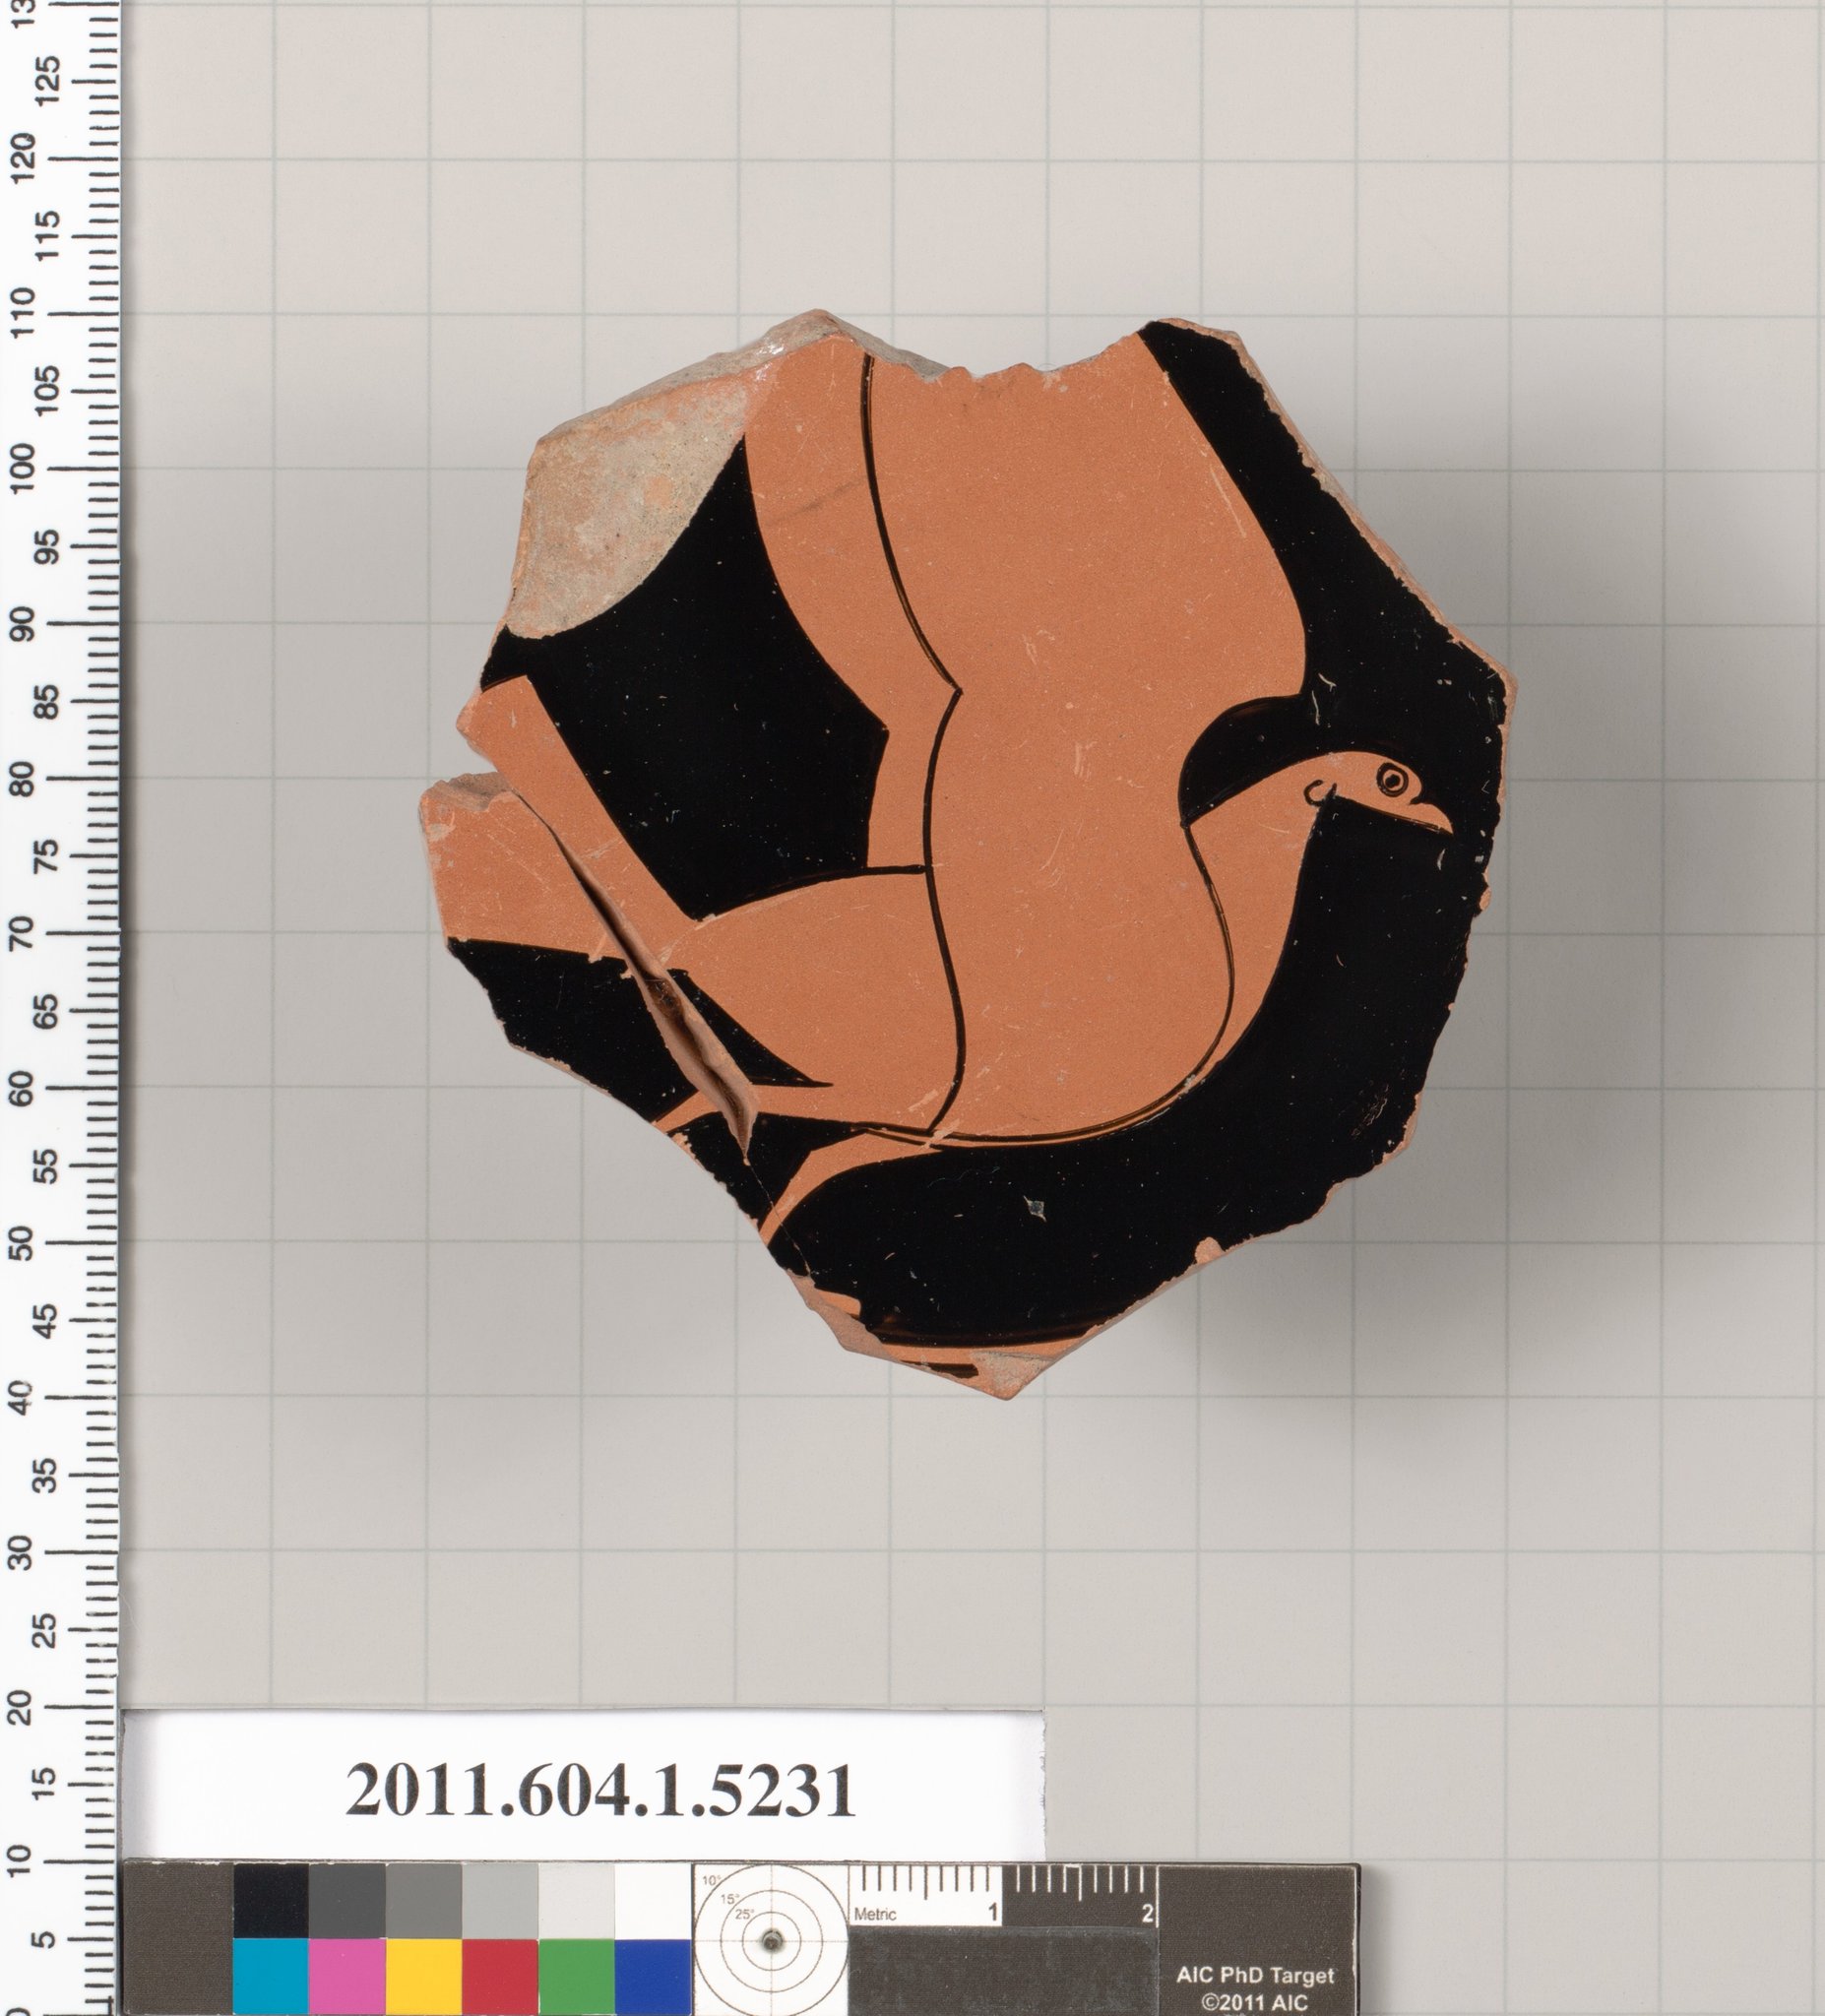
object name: kylix fragment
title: Terracotta fragment of a kylix (drinking cup)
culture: greek, attic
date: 520-510 BCE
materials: terracotta